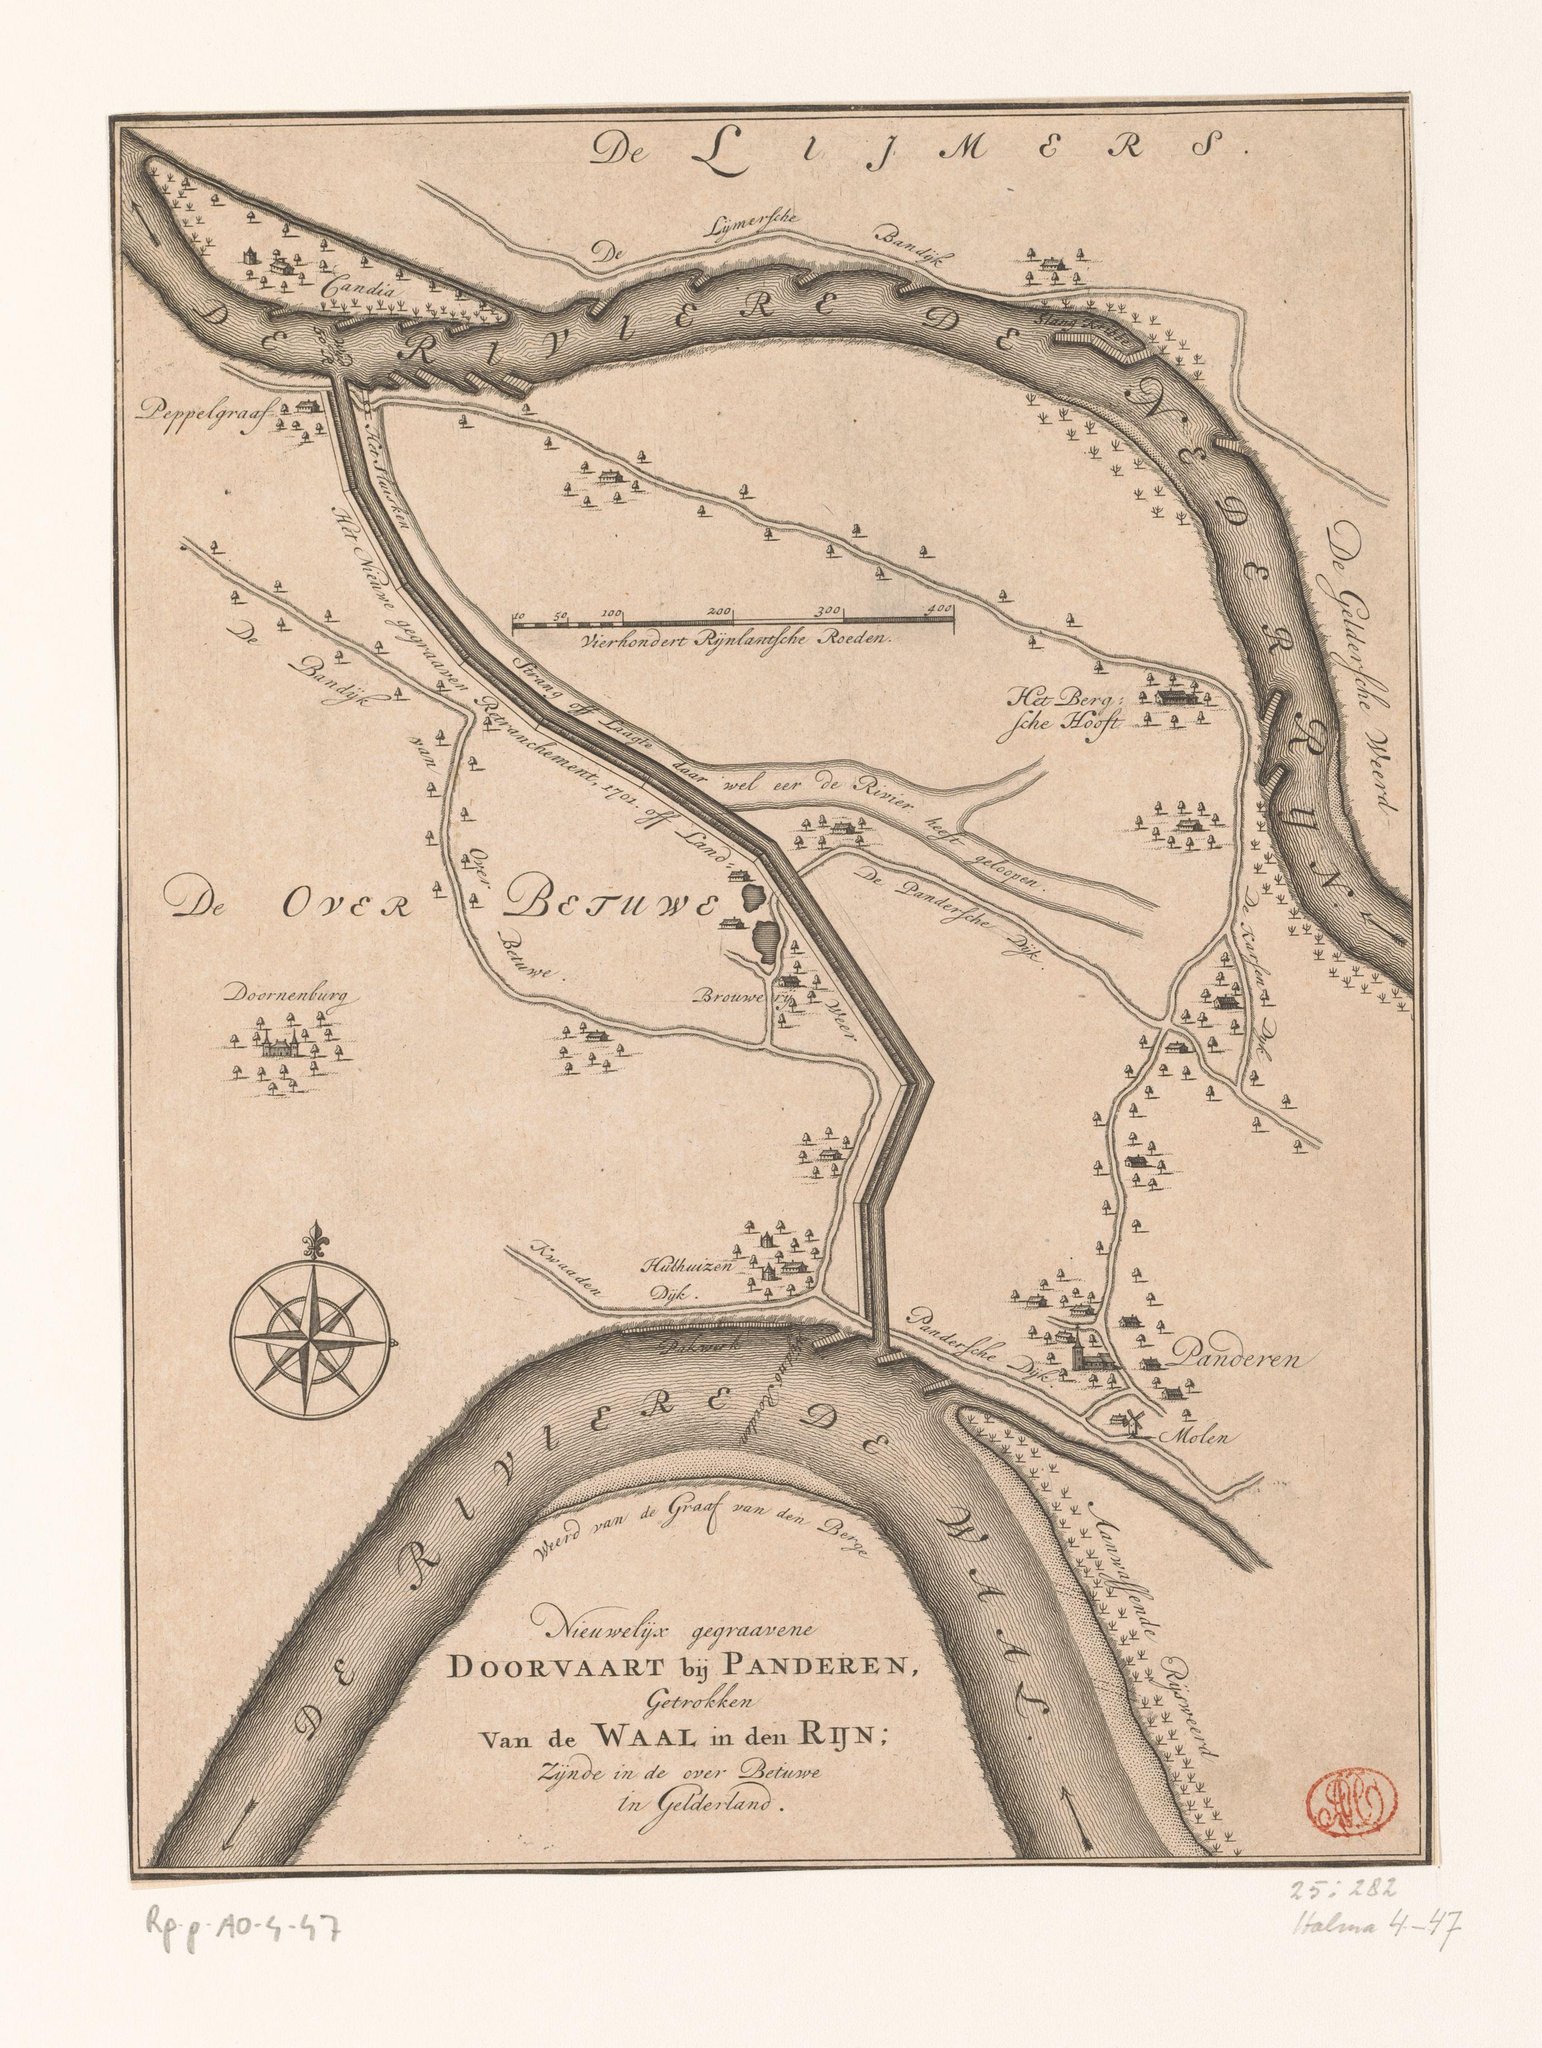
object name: print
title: Kaart met het kanaal tussen de Nederrijn en de Waal bij Pannerden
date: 1718-1727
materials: paper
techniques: engraving, etching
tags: maps of separate countries or regions, canal, lower rhine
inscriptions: collector's mark: Lugt 2228, collector's mark: Lugt 195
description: Onder, in het midden, de titel. Aan de bovenkant, in het midden, een schaalstok: Vierhondert Rijnlantsche Roeden.